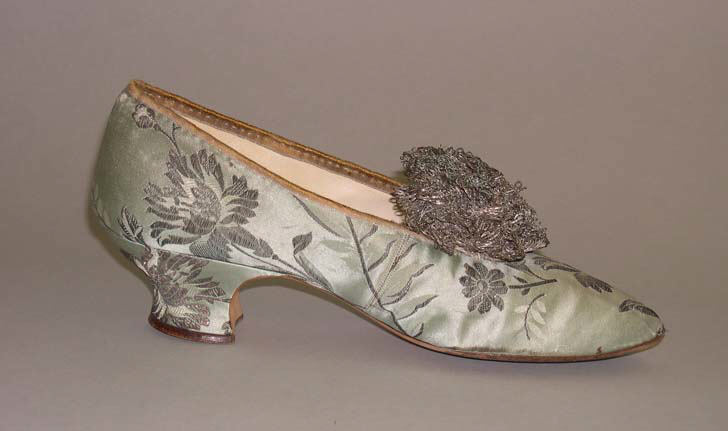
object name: slipper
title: Slippers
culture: american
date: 1891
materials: metal thread, silk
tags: flowers